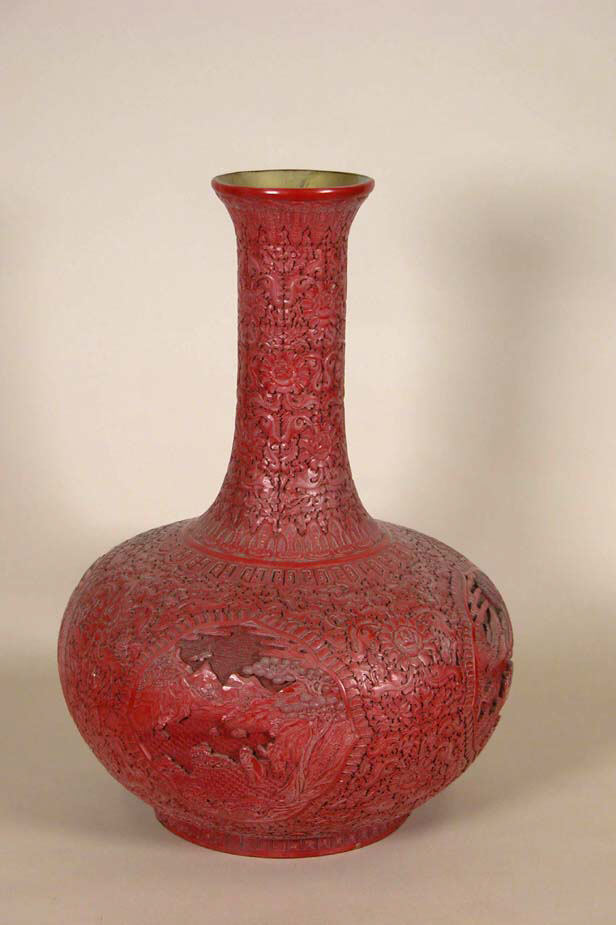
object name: vase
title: Vase with peony scroll and landscape panels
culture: chinese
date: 1801-1900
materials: lacquer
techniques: carving